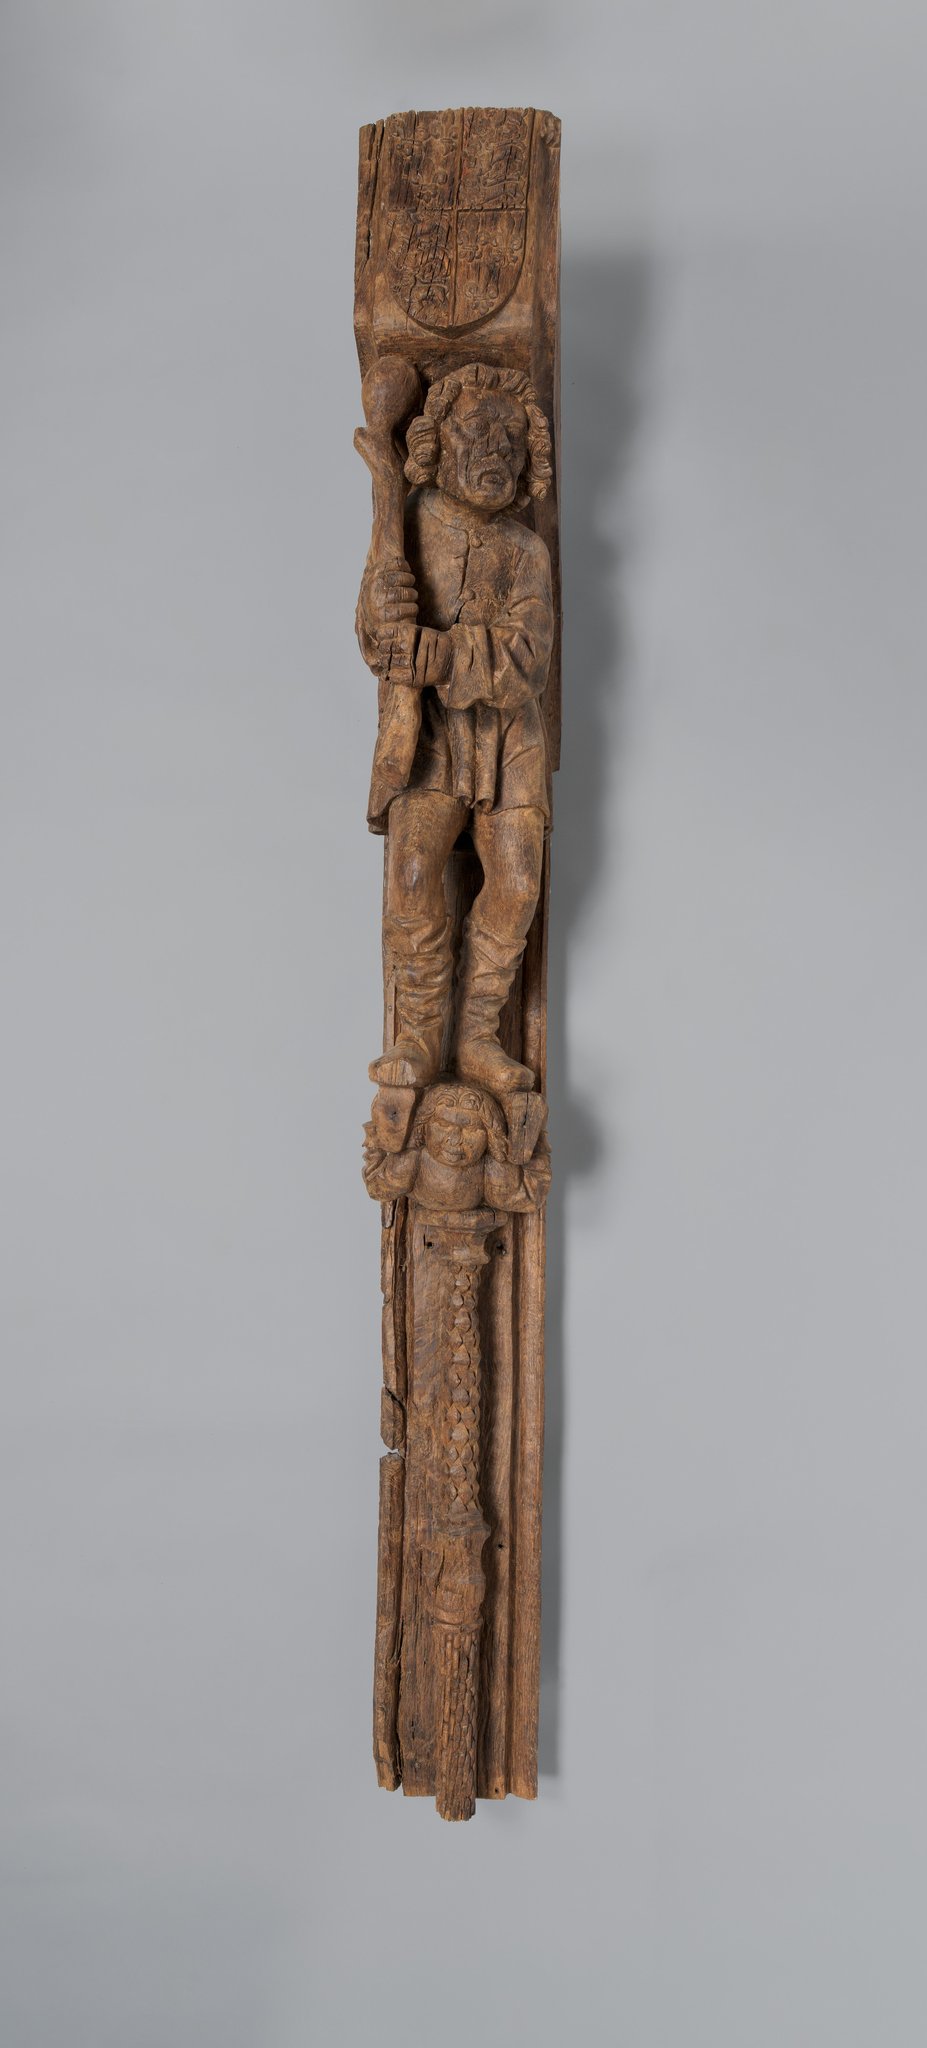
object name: support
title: Architectural Support with a Peasant Holding a Club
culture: french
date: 1524-1525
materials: wood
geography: england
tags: men